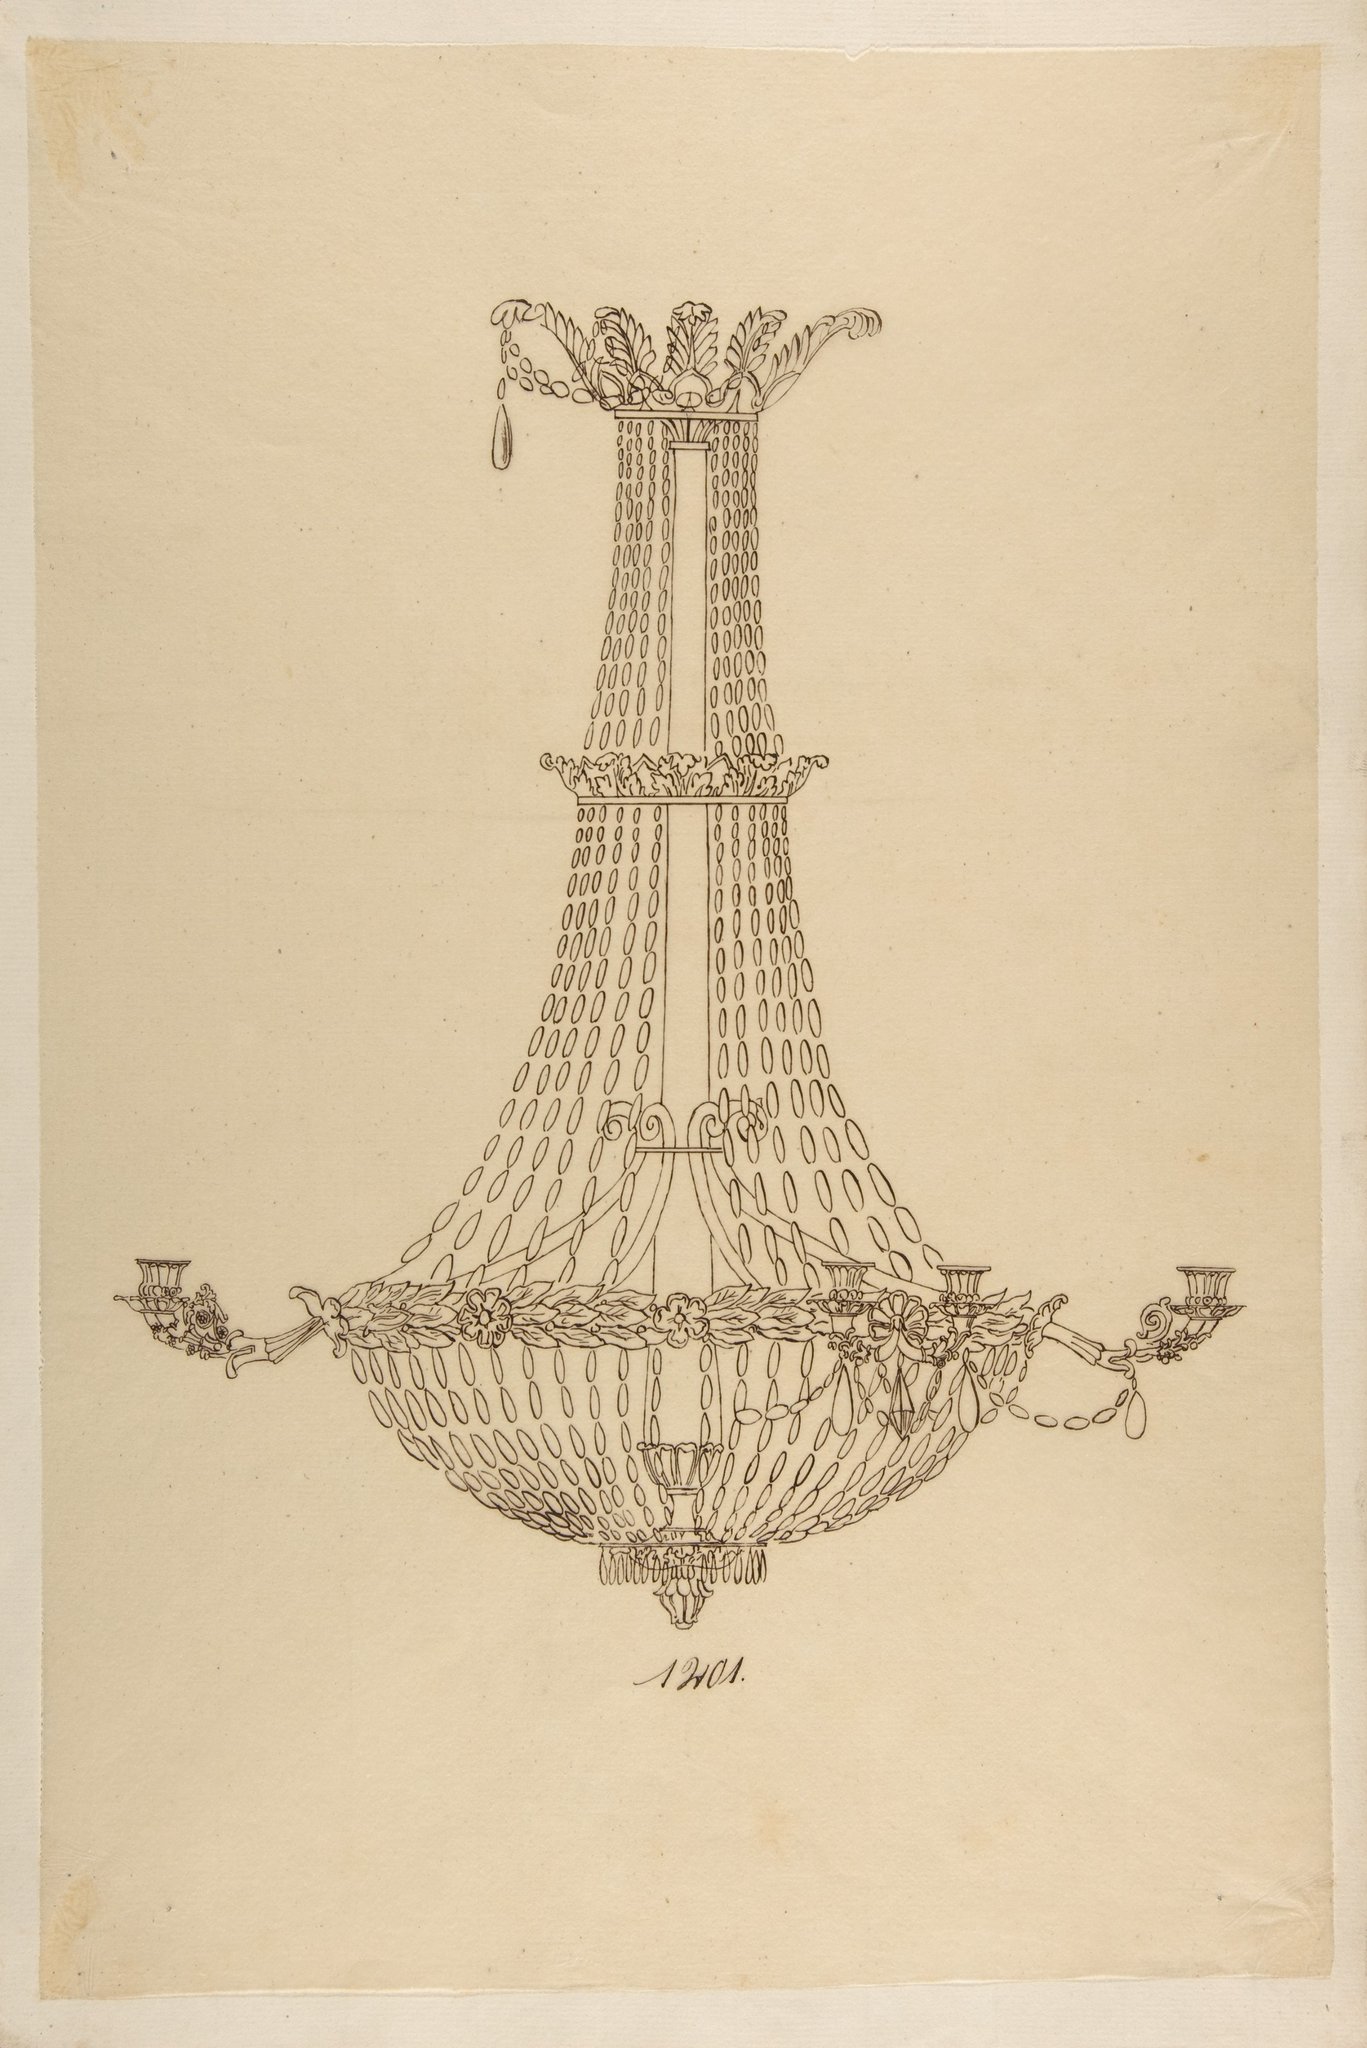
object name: drawing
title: Design for a Chandelier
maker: anonymous, french, 19th century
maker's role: artist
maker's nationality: french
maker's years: 1800-1900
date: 1801-1900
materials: ink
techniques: pen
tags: chandelier